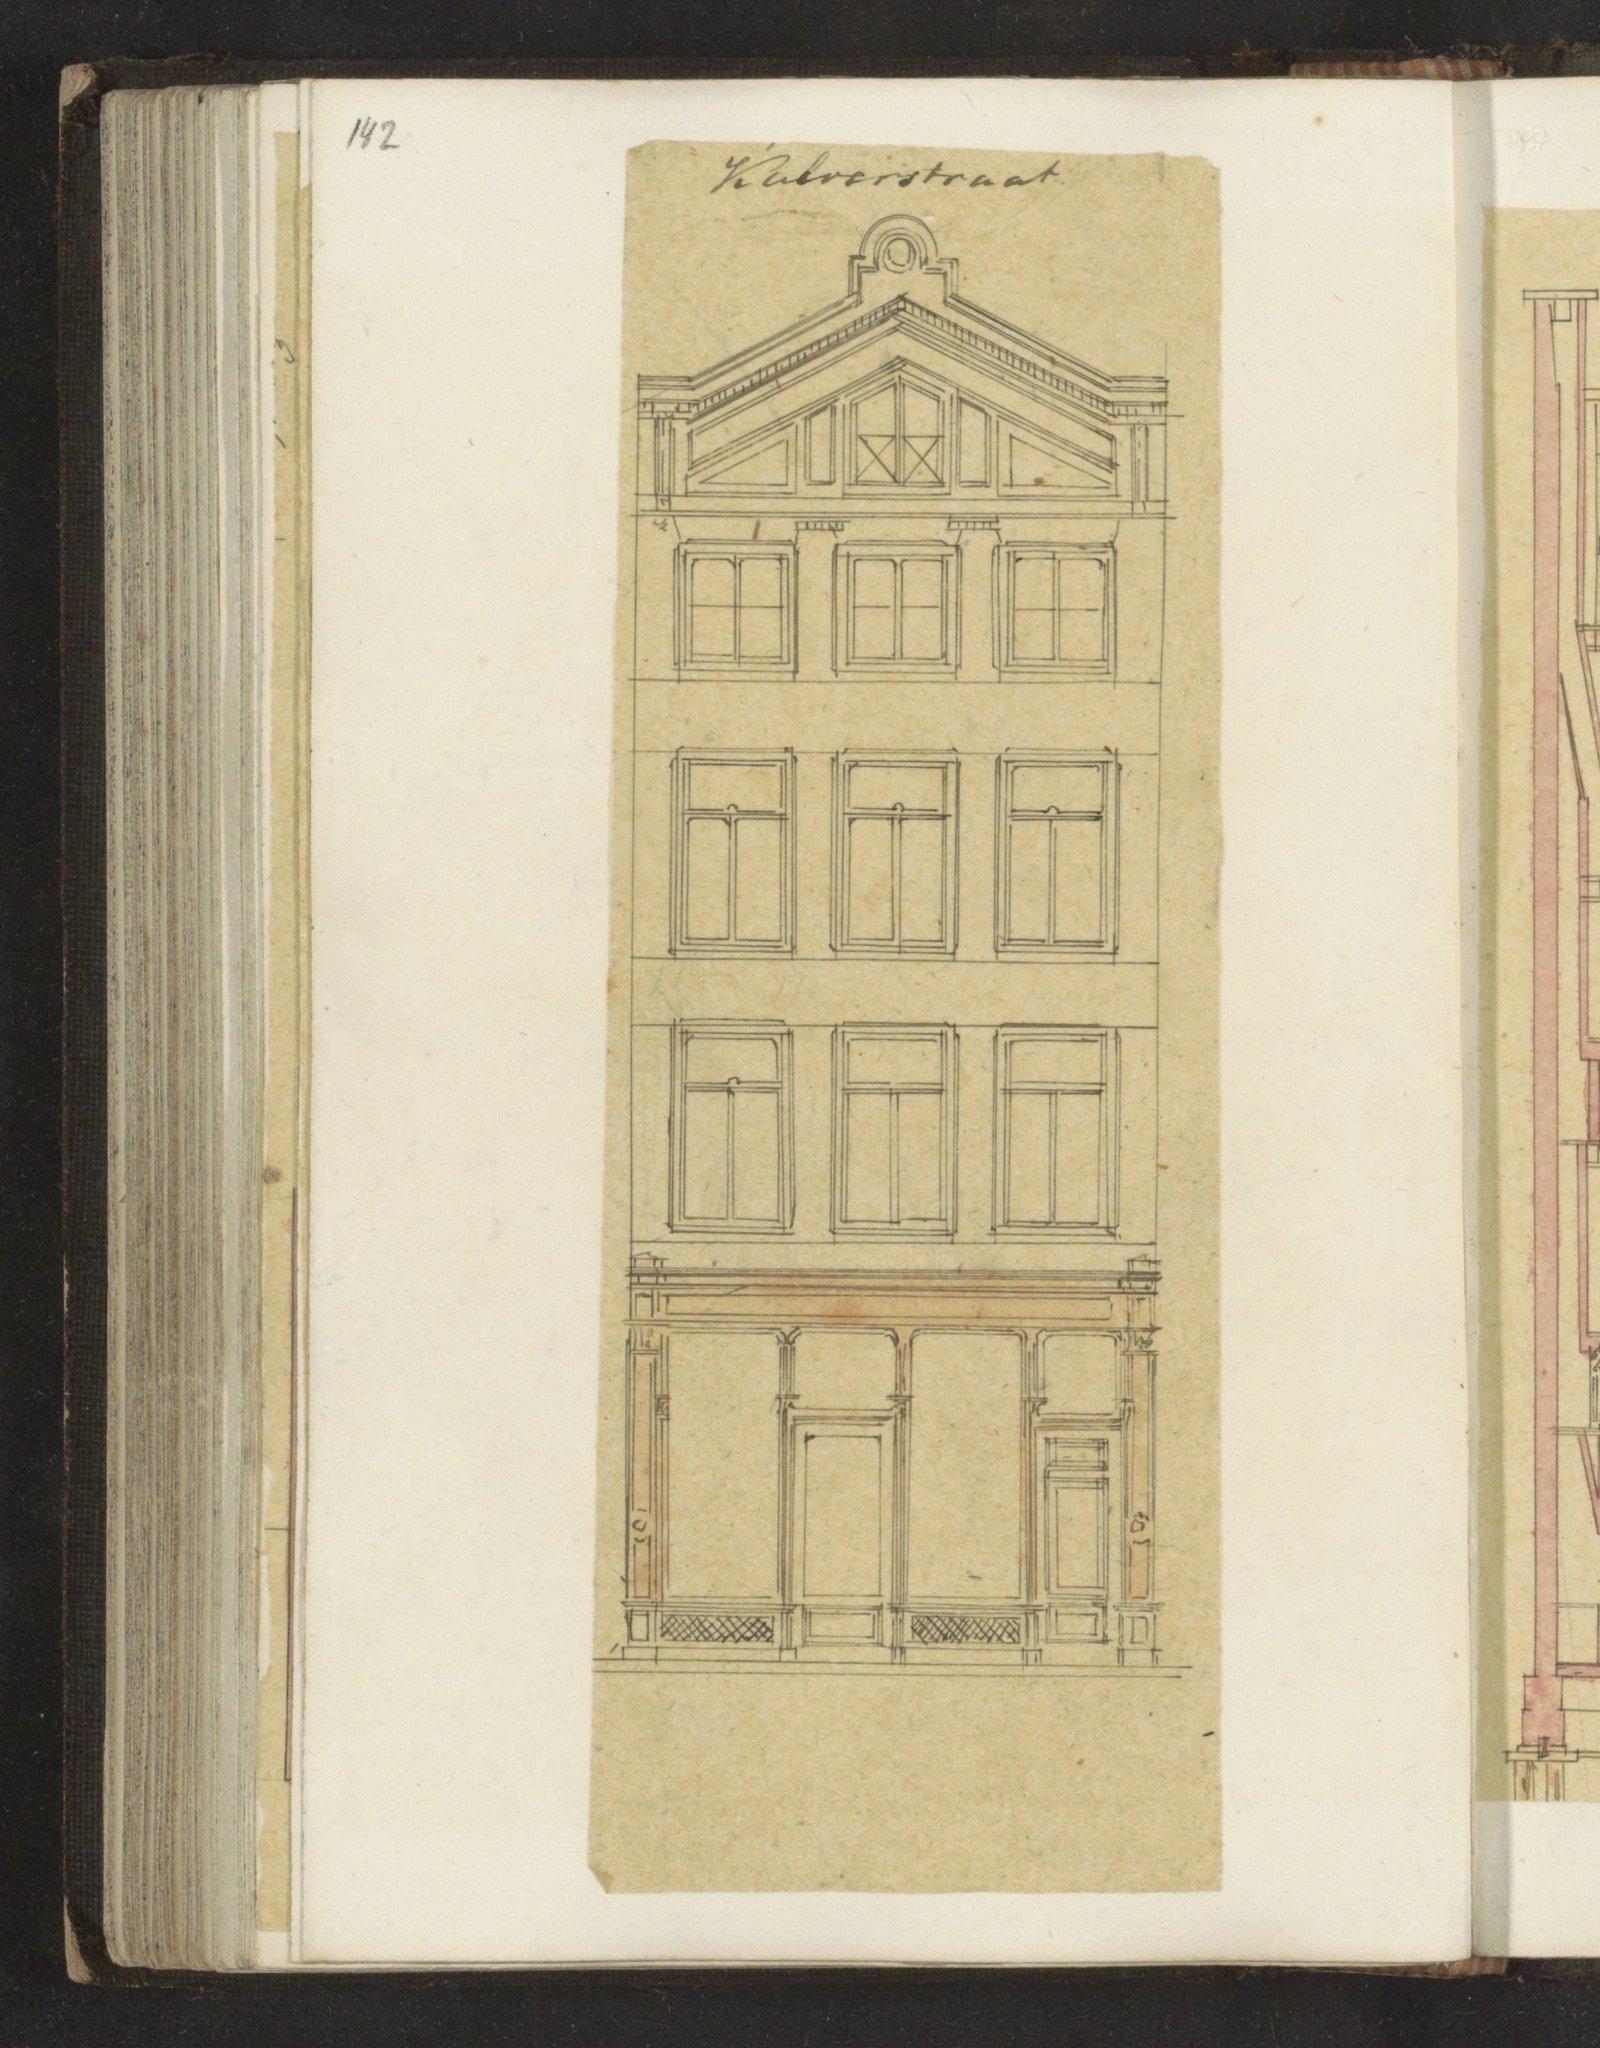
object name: sketchbook leaf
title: Opstand van de pui van een winkelpand aan de Kalverstraat te Amsterdam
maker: willem springer jr.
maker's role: draughtsman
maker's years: 1815-1907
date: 1864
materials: ink, paper, pencil, watercolor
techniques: brush, pen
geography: amsterdam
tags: façade (of house or building)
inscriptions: annotation: ‘Kalverstraat’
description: Pagina 142 uit een schetsboek met 164 pagina's.